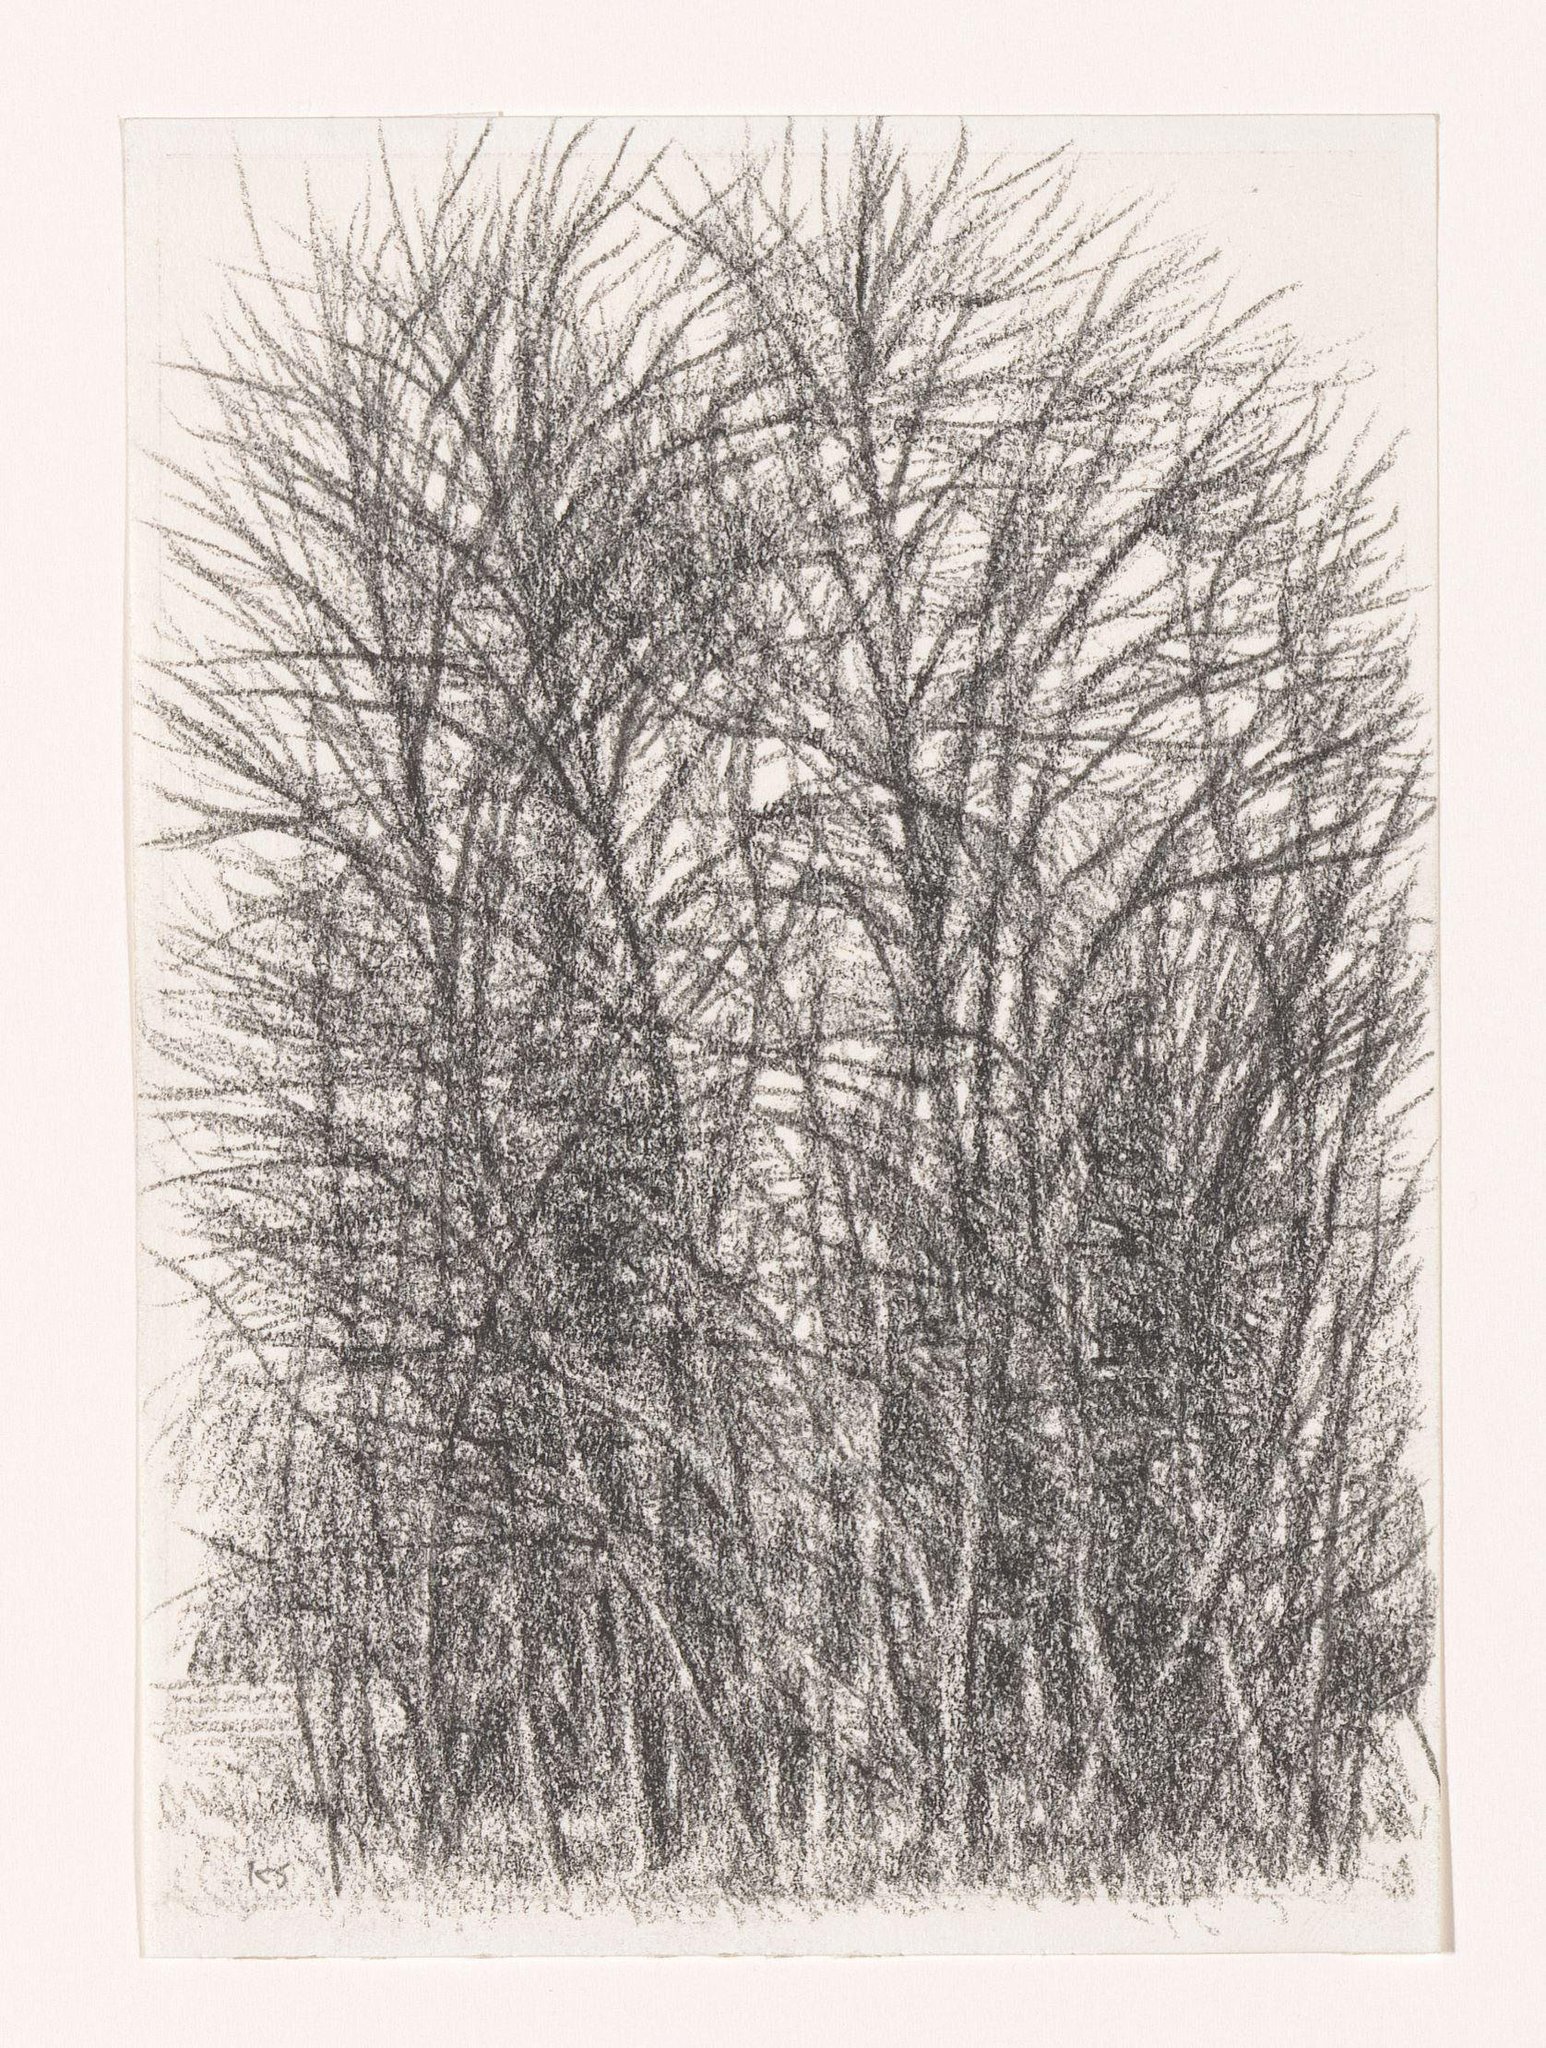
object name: drawing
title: Bomen zonder blad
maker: kees stoop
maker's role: draughtsman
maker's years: 1929-2019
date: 1939-2009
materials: charcoal, paper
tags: groups of trees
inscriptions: signature: ‘KS’